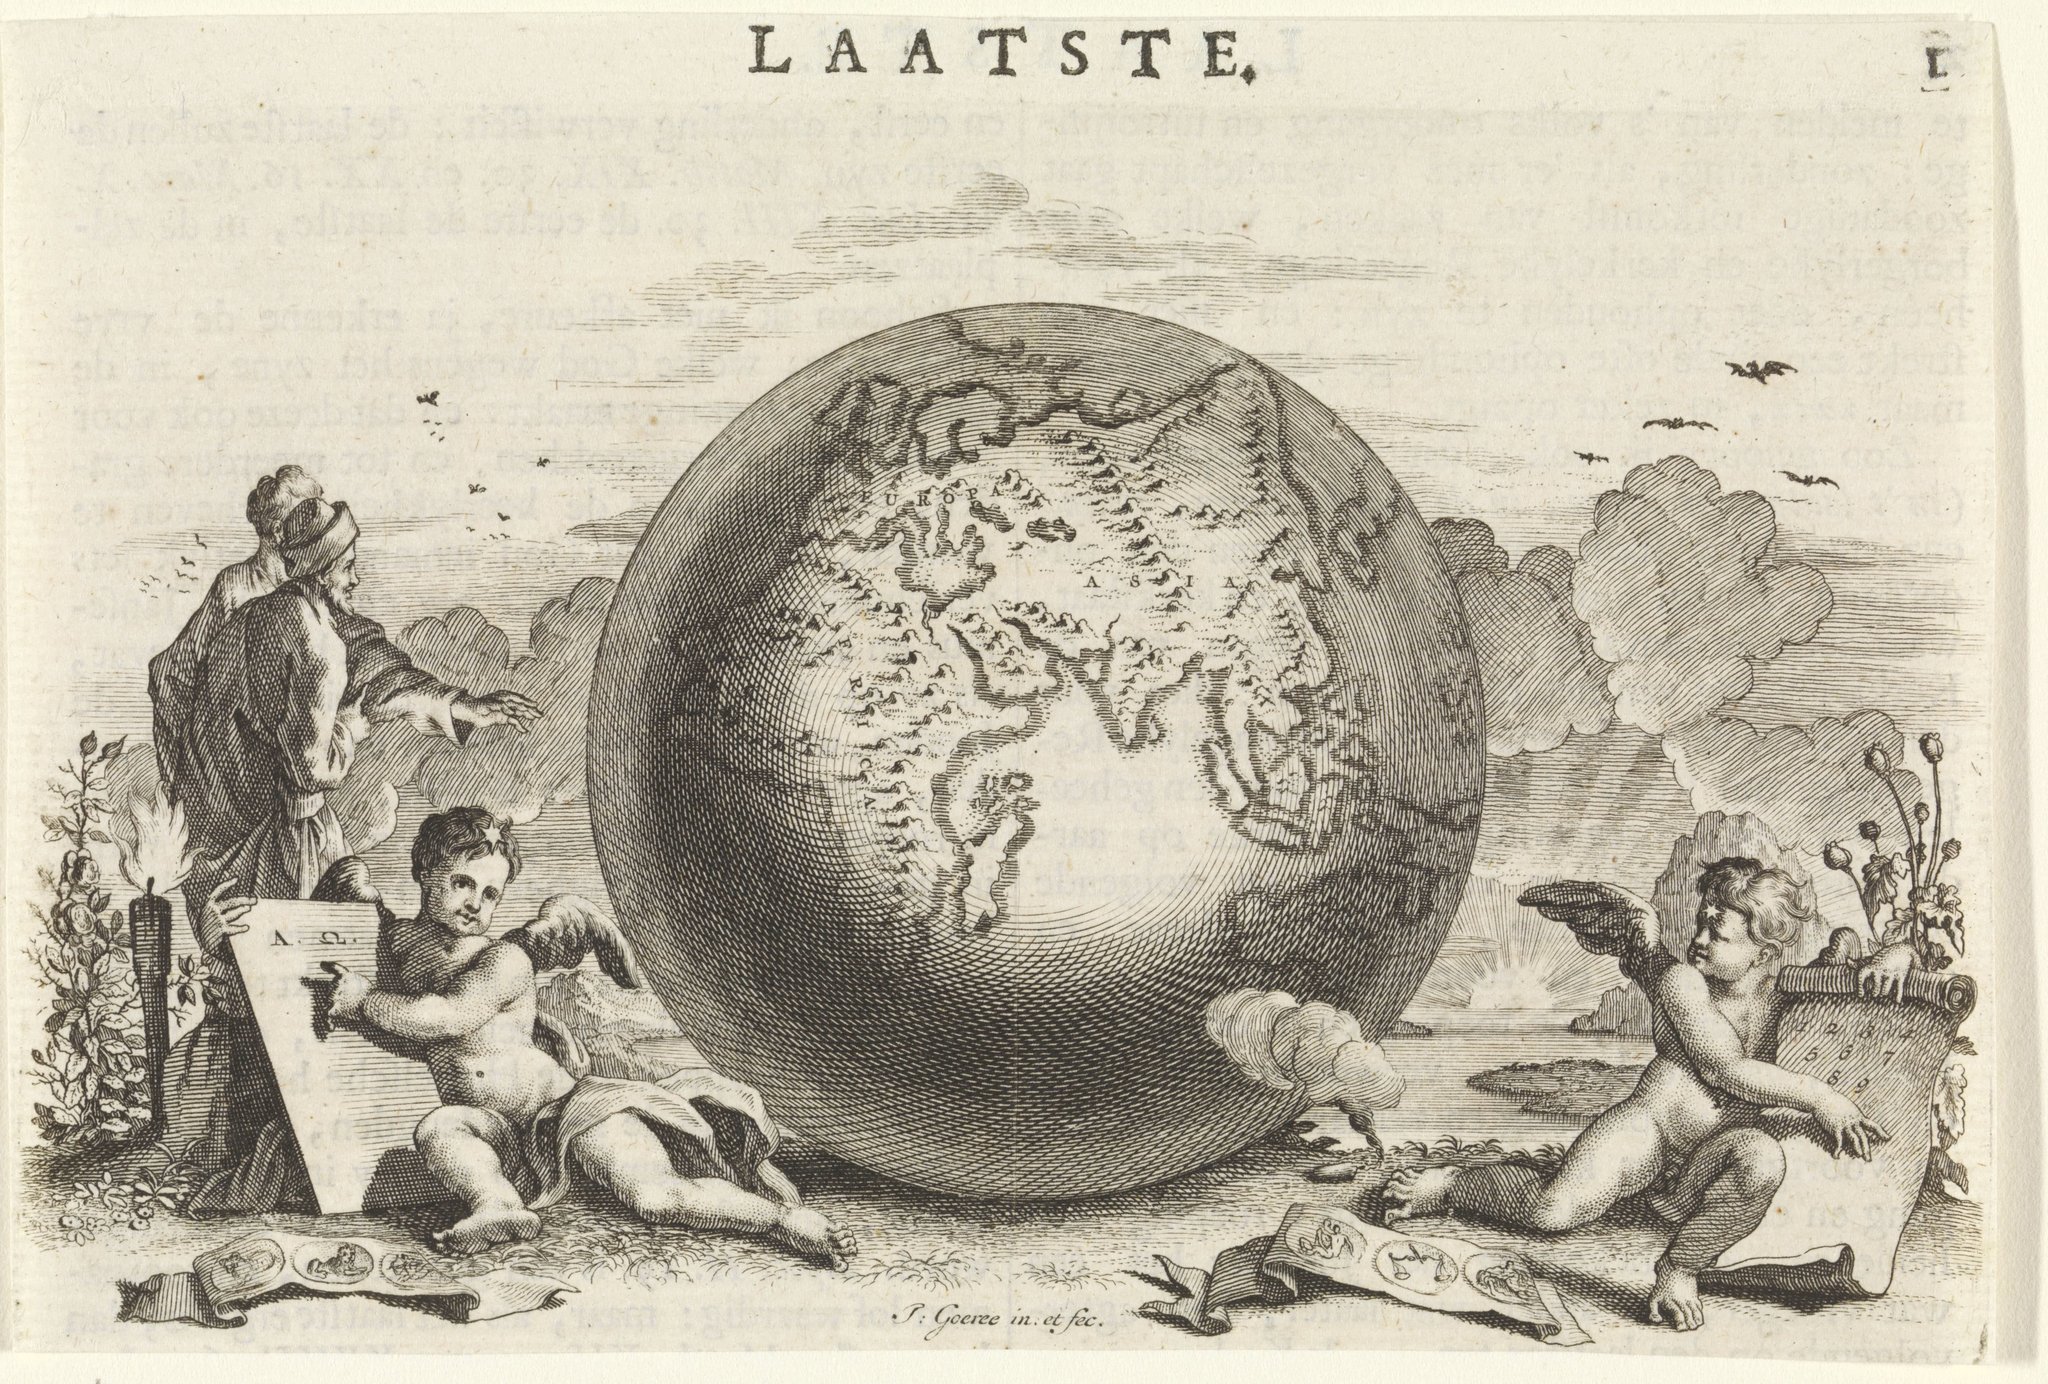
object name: book illustration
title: Putti aan weerszijden van een wereldbol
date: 1723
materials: paper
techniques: engraving, letterpress printing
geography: amsterdam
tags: zodiac; the twelve zodiacal signs together, globe, cupids: 'amores', 'amoretti', 'putti', number symbolism, alpha and omega ~ symbol of god the father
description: In het midden een wereldbol, een cirkel zonder einde. Aan weerszijden van de wereldbol een putto. De linker wijst naar een plaat, waarop de griekse letters Alpha en Omega. Aan zijn voeten een banderol met de sterrentekens Ram, Leeuw, Steenbok. De putto rechts wijst naar een papierrol, waarop de cijfers 1 tot en met 9. Aan zijn voeten een banderol met de sterrentekens Tweeling, Weegschaal, Waterman. Op de achtergrond de einder met ondergaande zon.